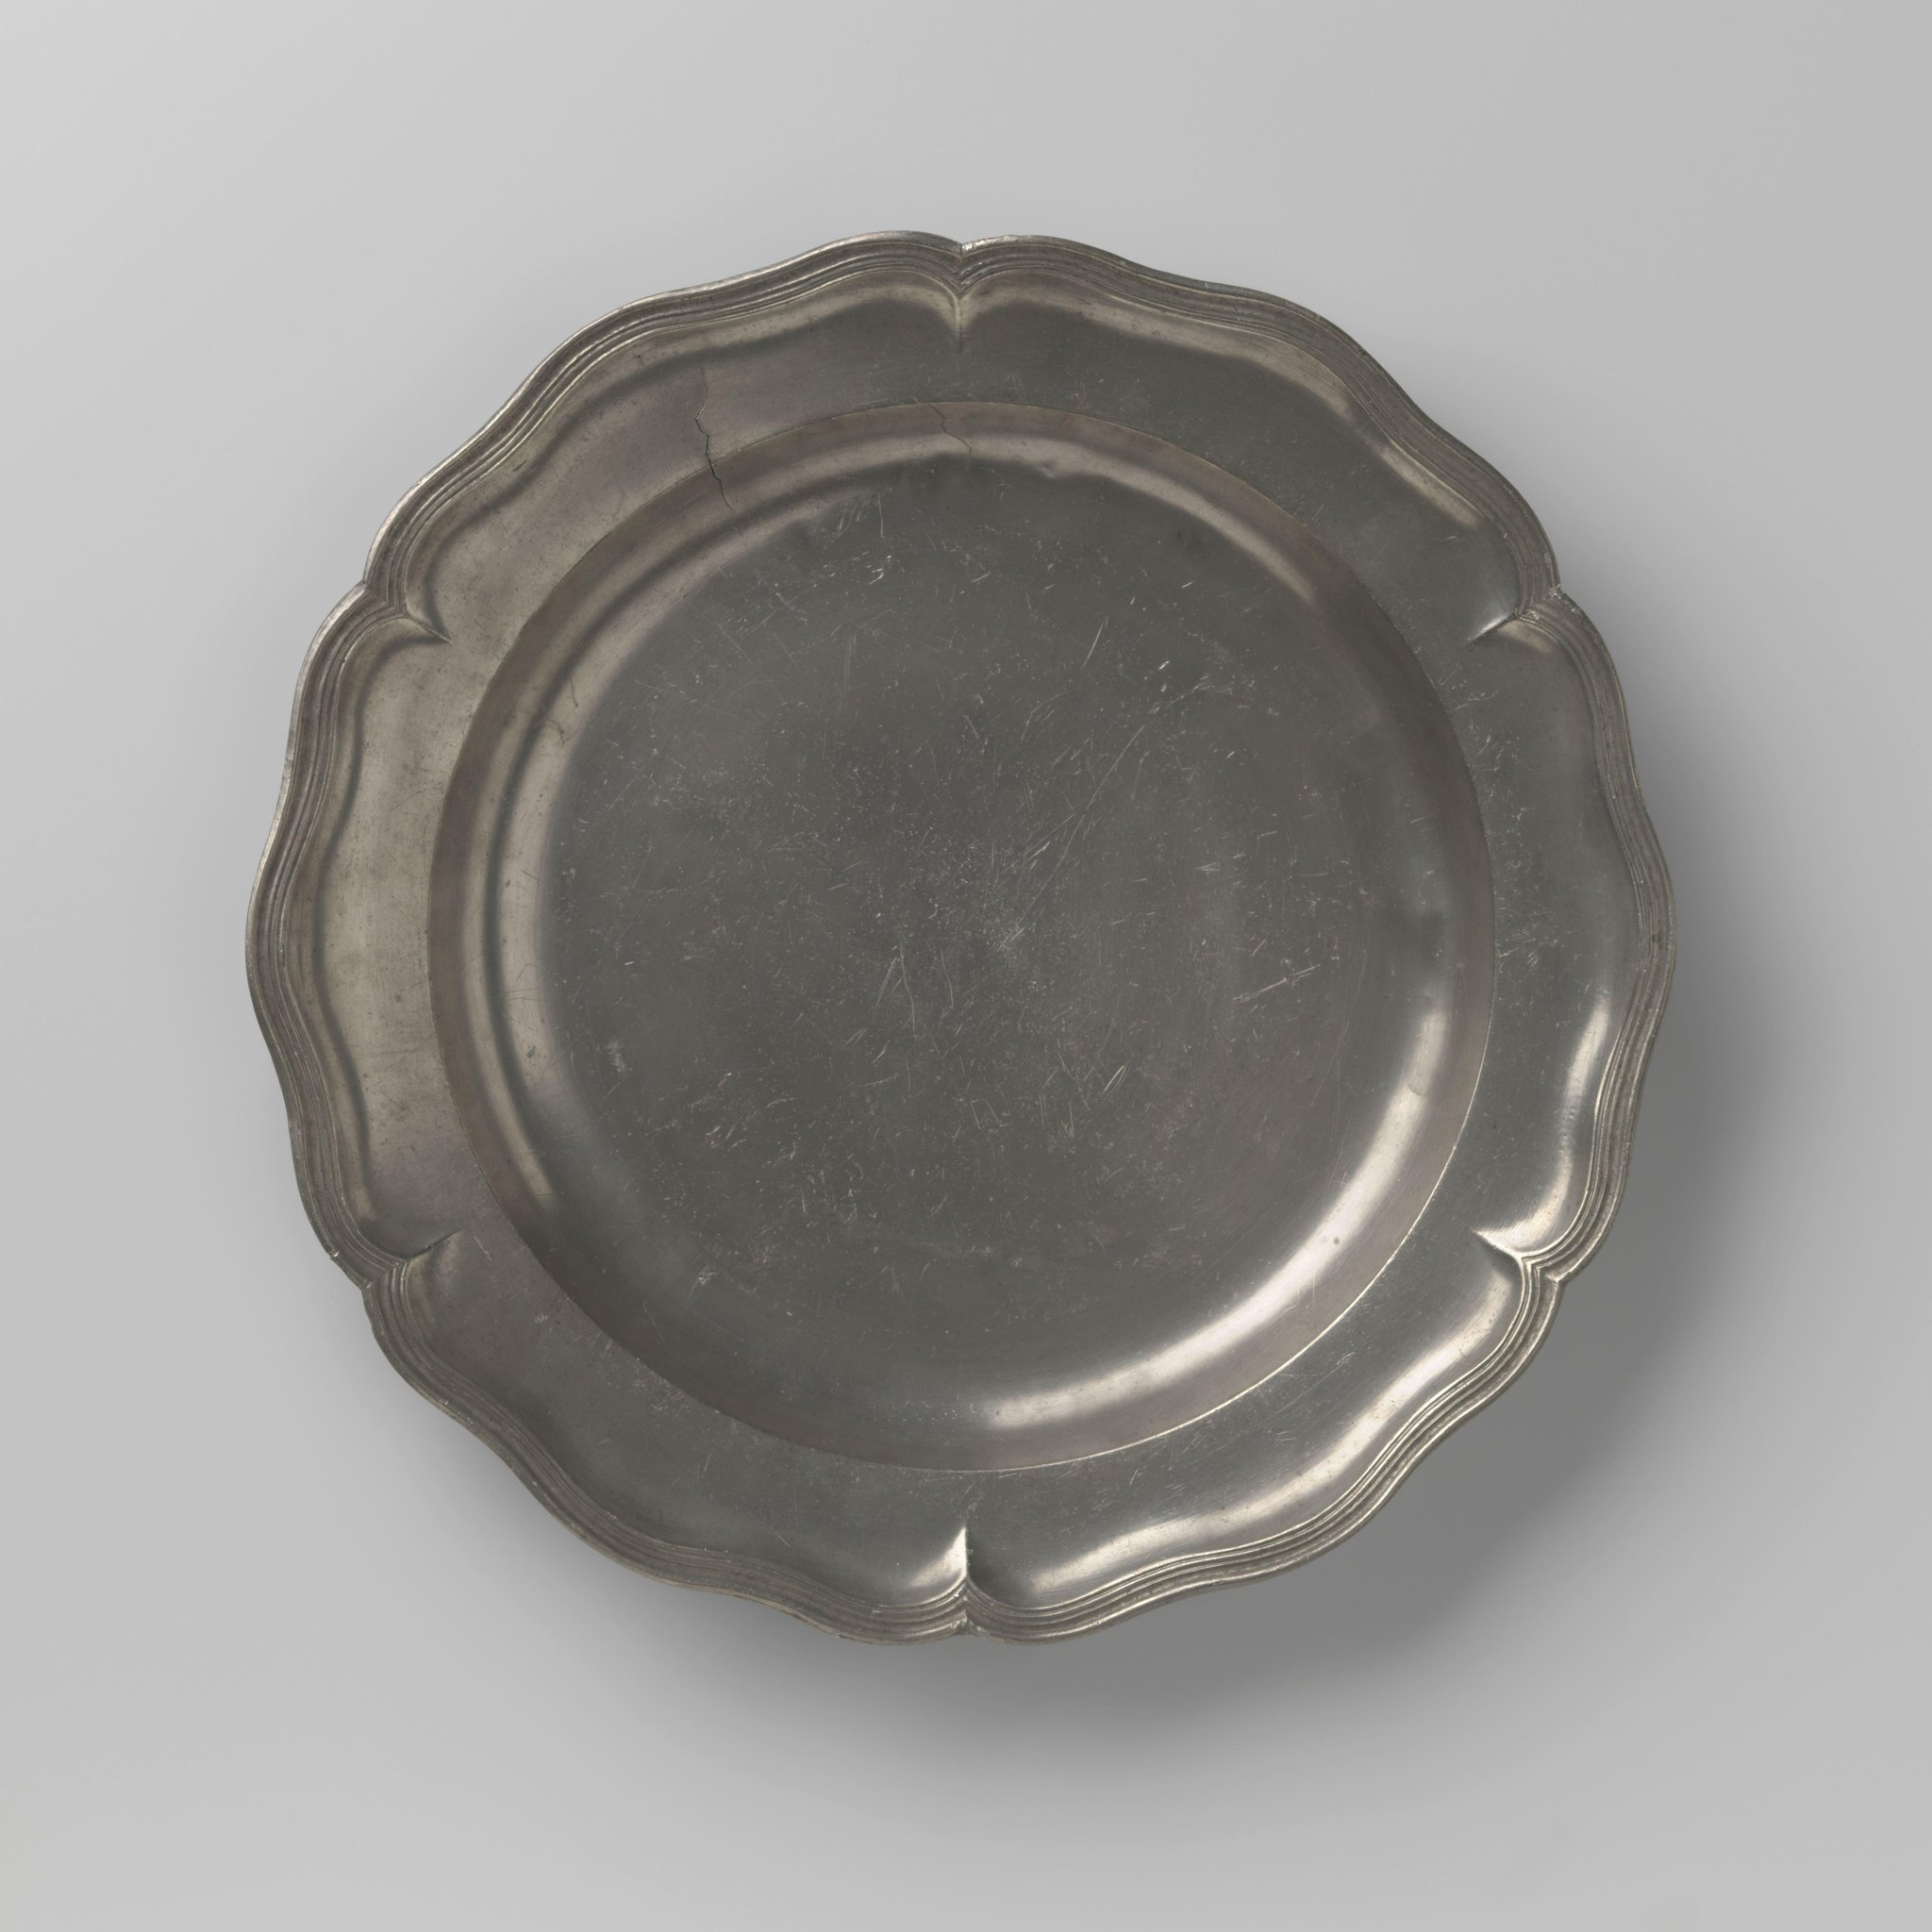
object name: platter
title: Schotel met geschulpte rand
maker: carolus theodorus de ruijr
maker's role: pewterers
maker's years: 1749-1795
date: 1770-1795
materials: tin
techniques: casting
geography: roermond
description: Tinnen schotel met geschulpte rand. Gemerkt met een roos met kroon, waarin '6. Ru...' en de gerechtigheid.